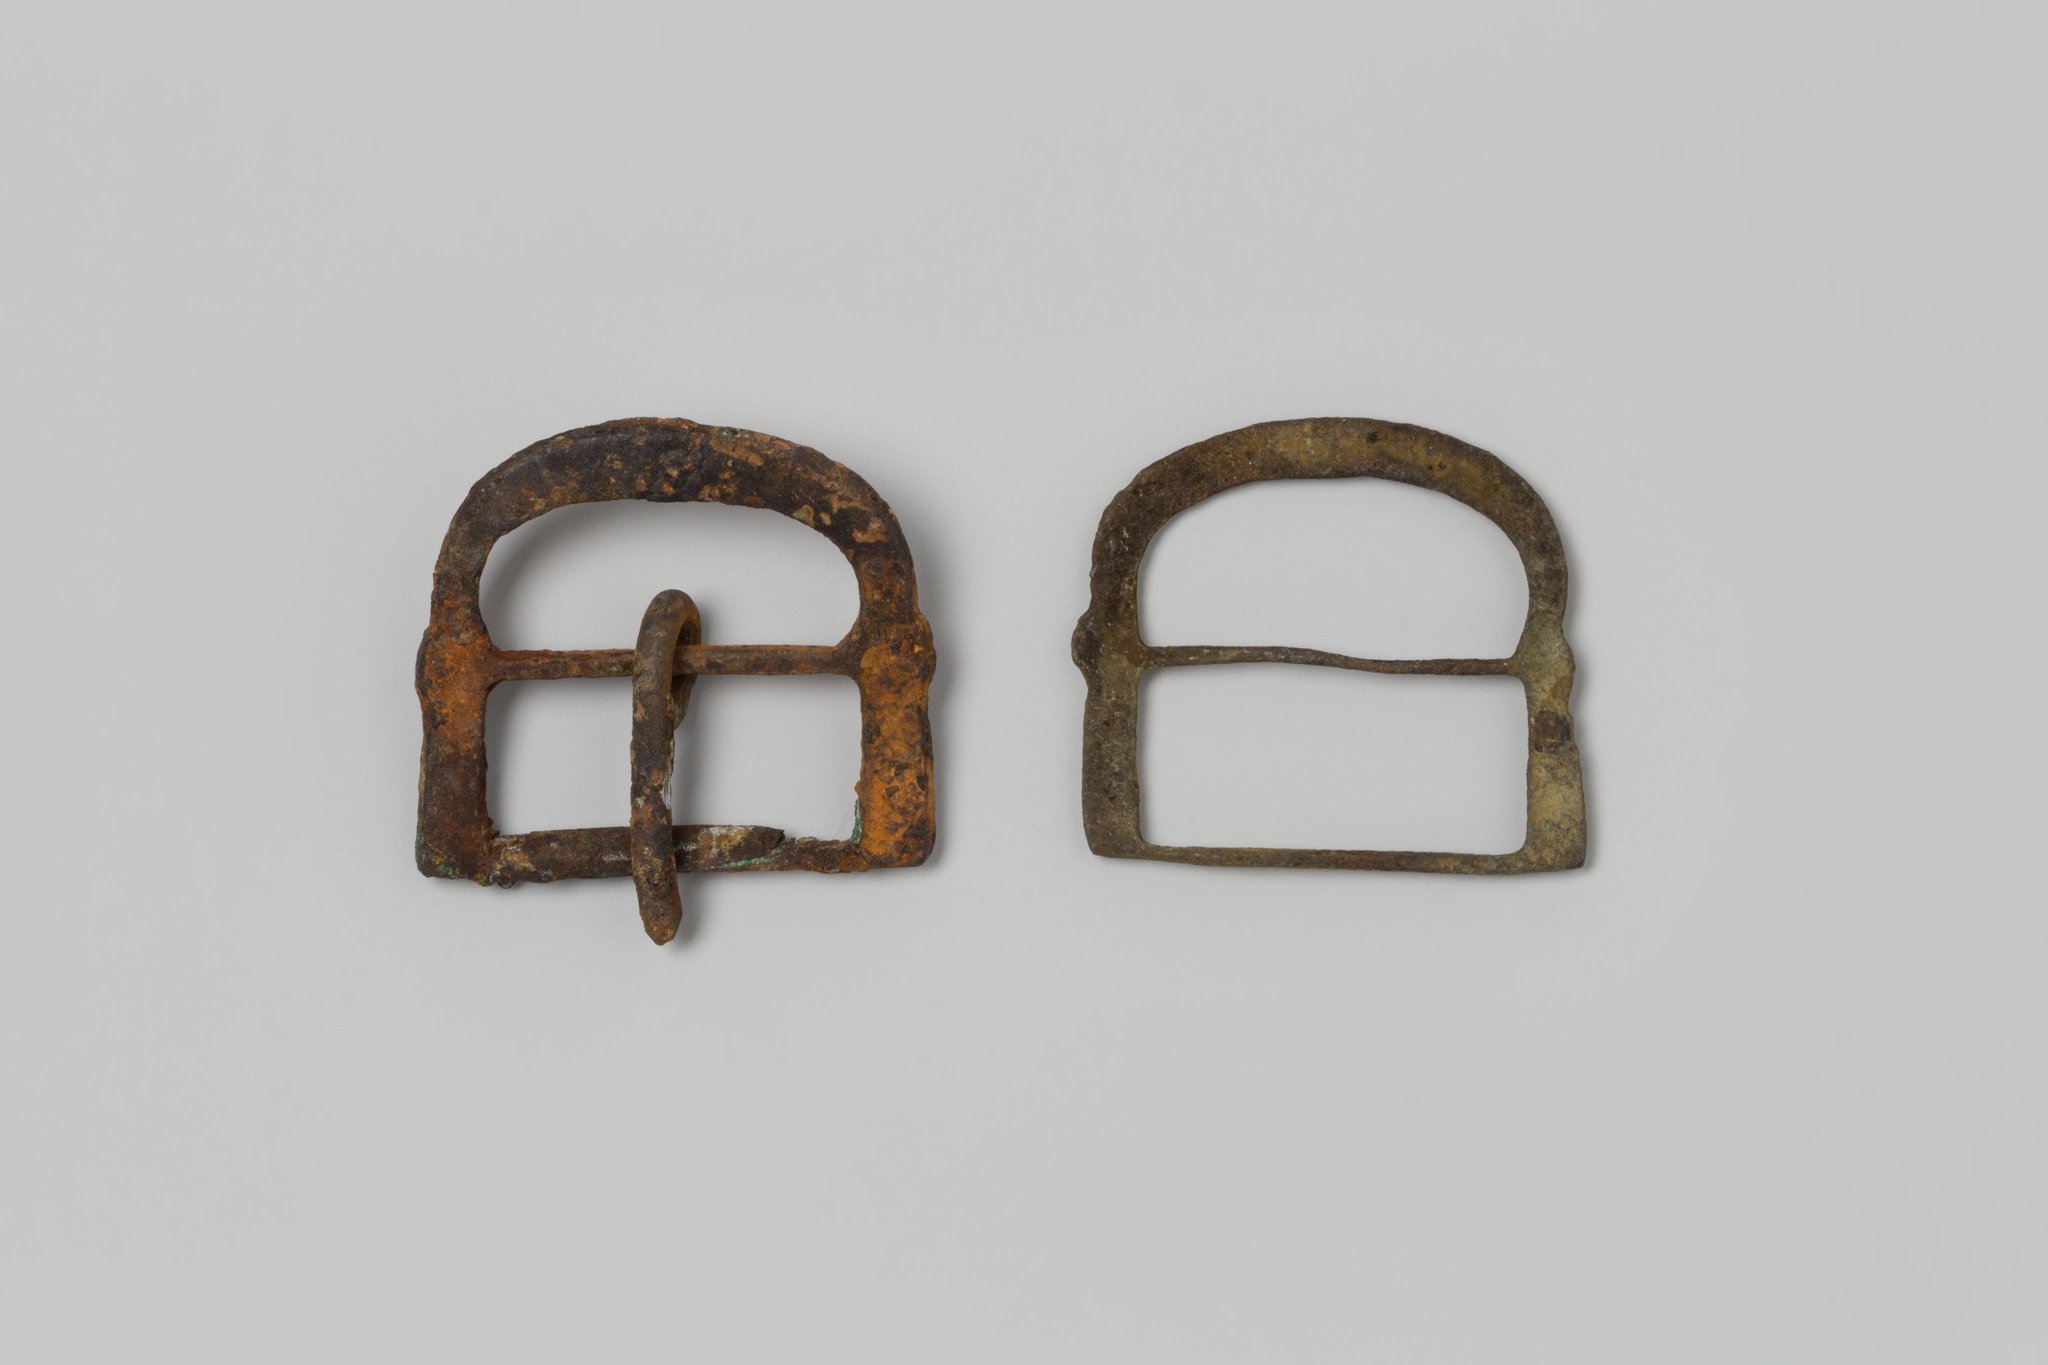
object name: belt buckle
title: Riemgesp uit het wrak van de Oost-Indiëvaarder Hollandia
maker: Anonymous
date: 1700-1743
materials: copper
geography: netherlands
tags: verenigde oostindische compagnie, hollandia (schip), annet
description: D-shaped, rings, with tongue, id. NG 1979-177H537 belt buckle.